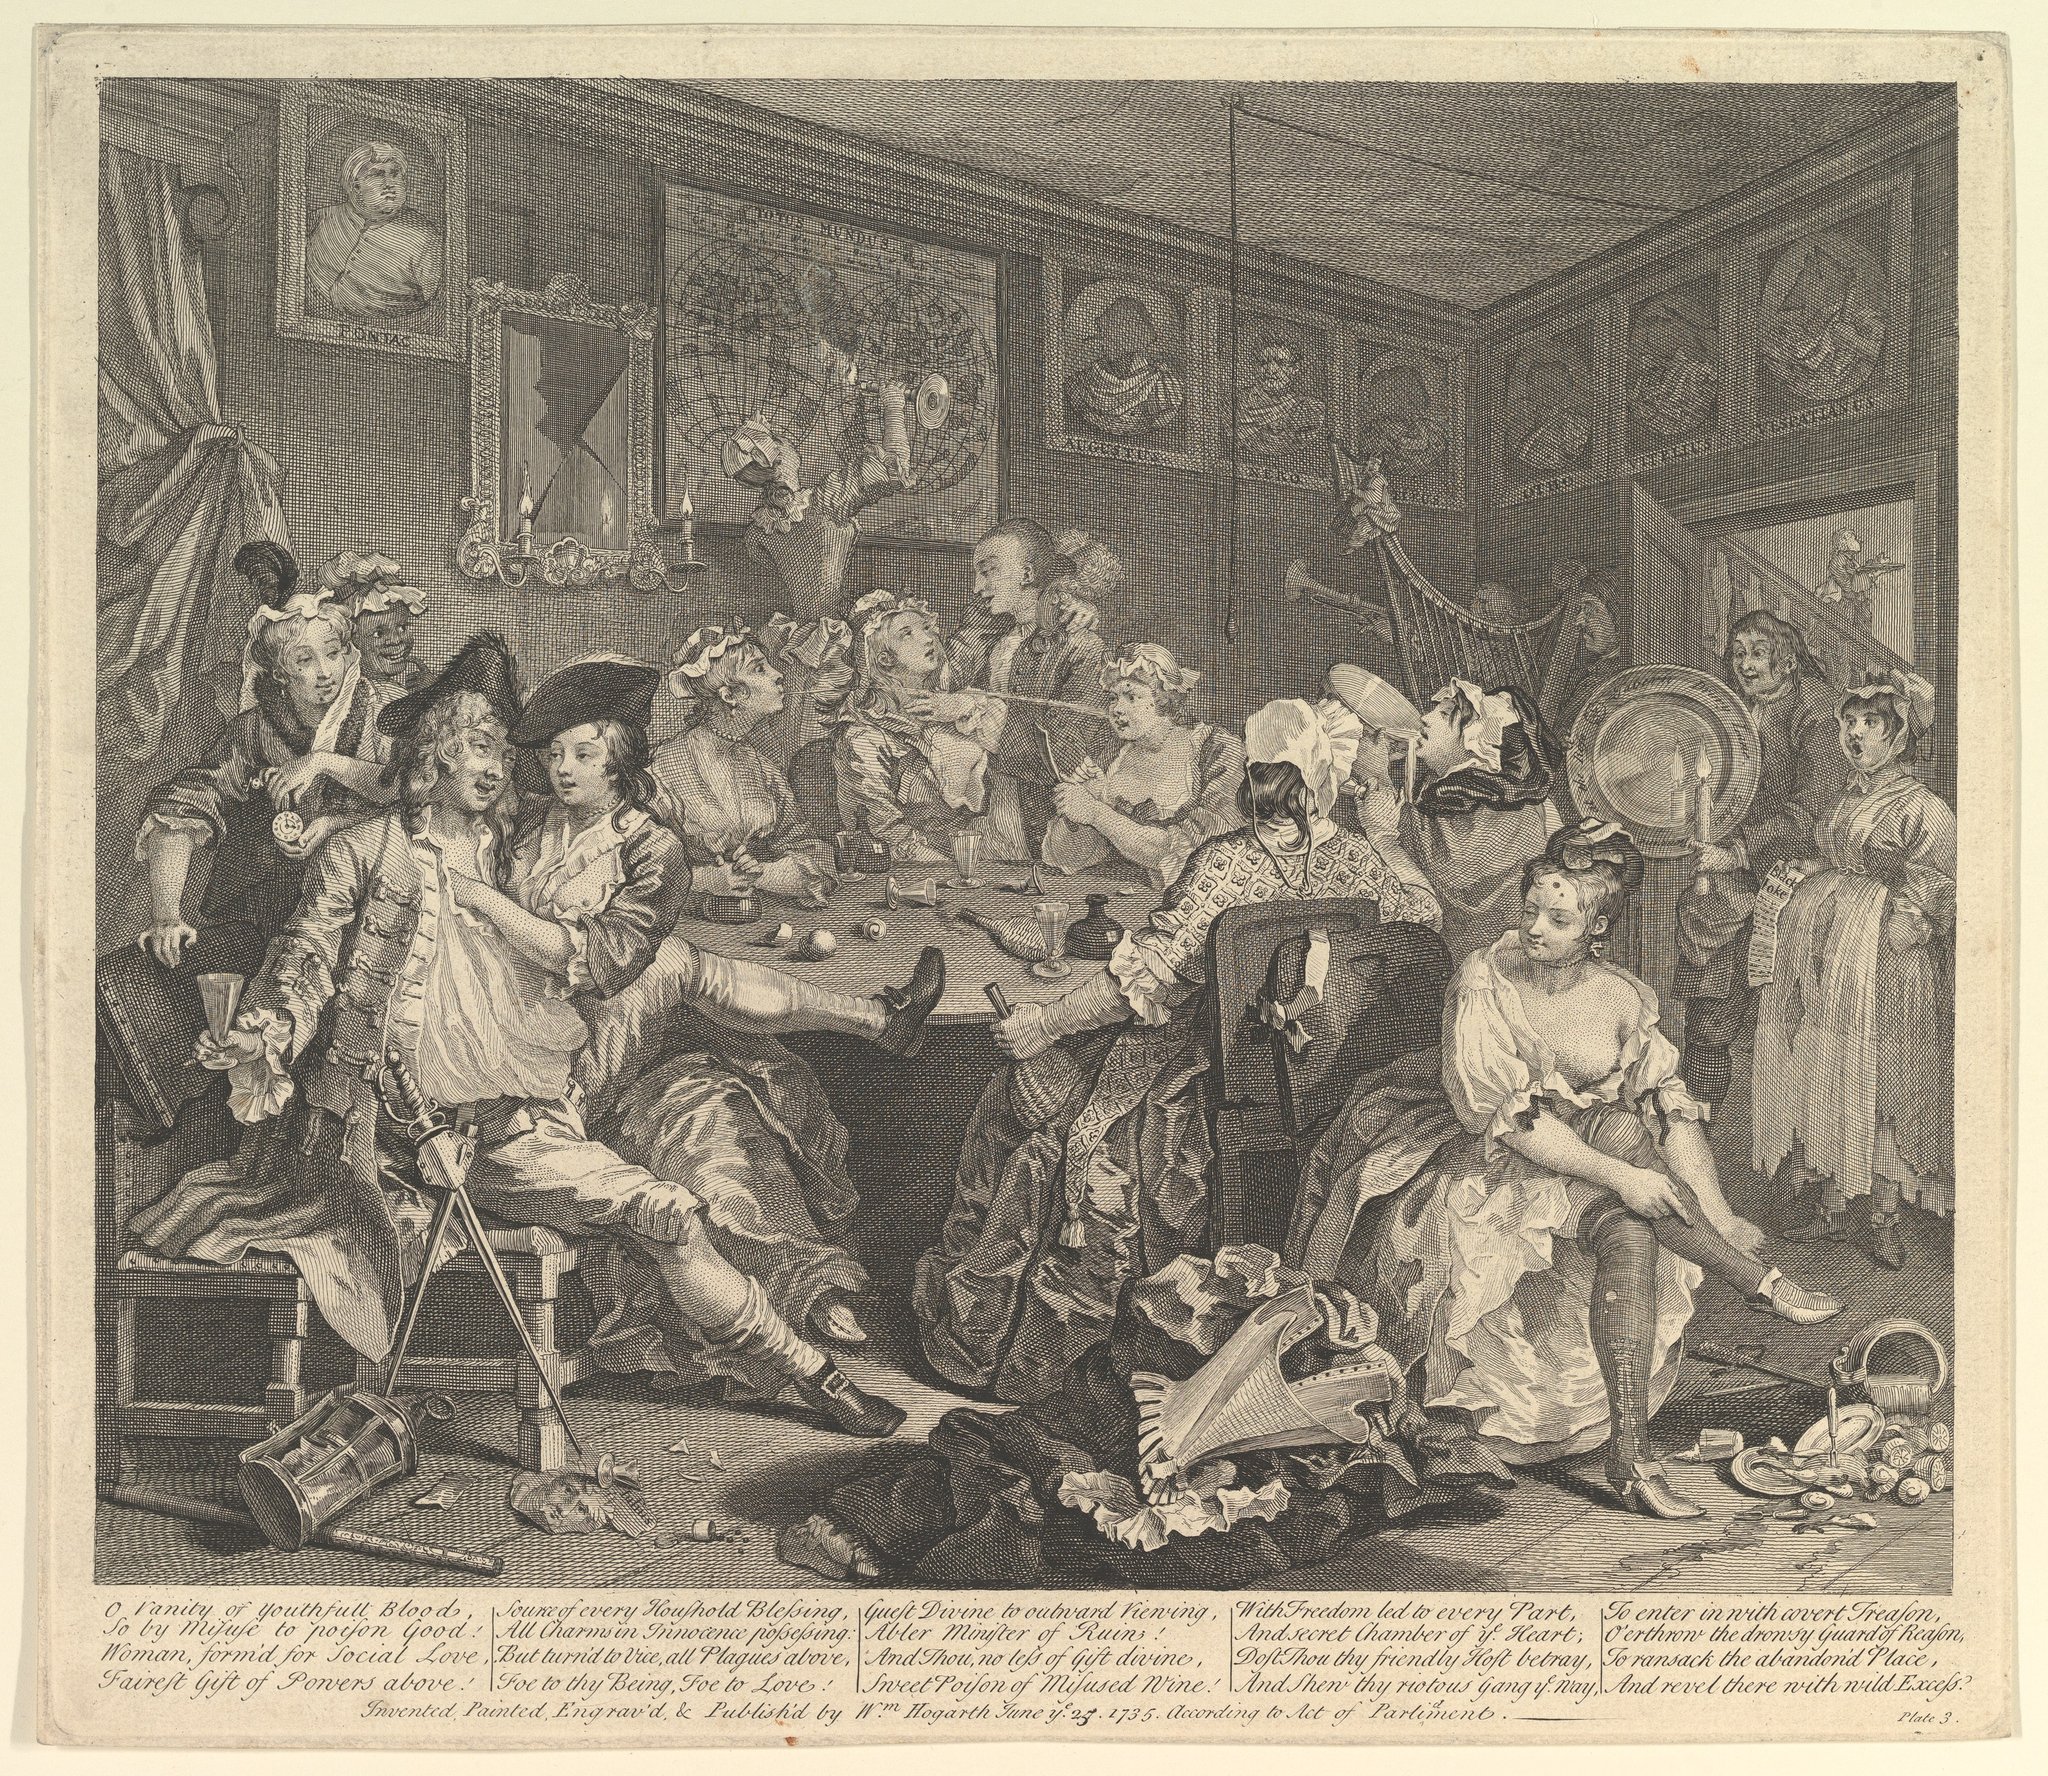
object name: print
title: A Rake's Progress, Plate 3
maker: william hogarth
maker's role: artist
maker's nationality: british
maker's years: 1697-1764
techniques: engraving, etching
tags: men,women,party